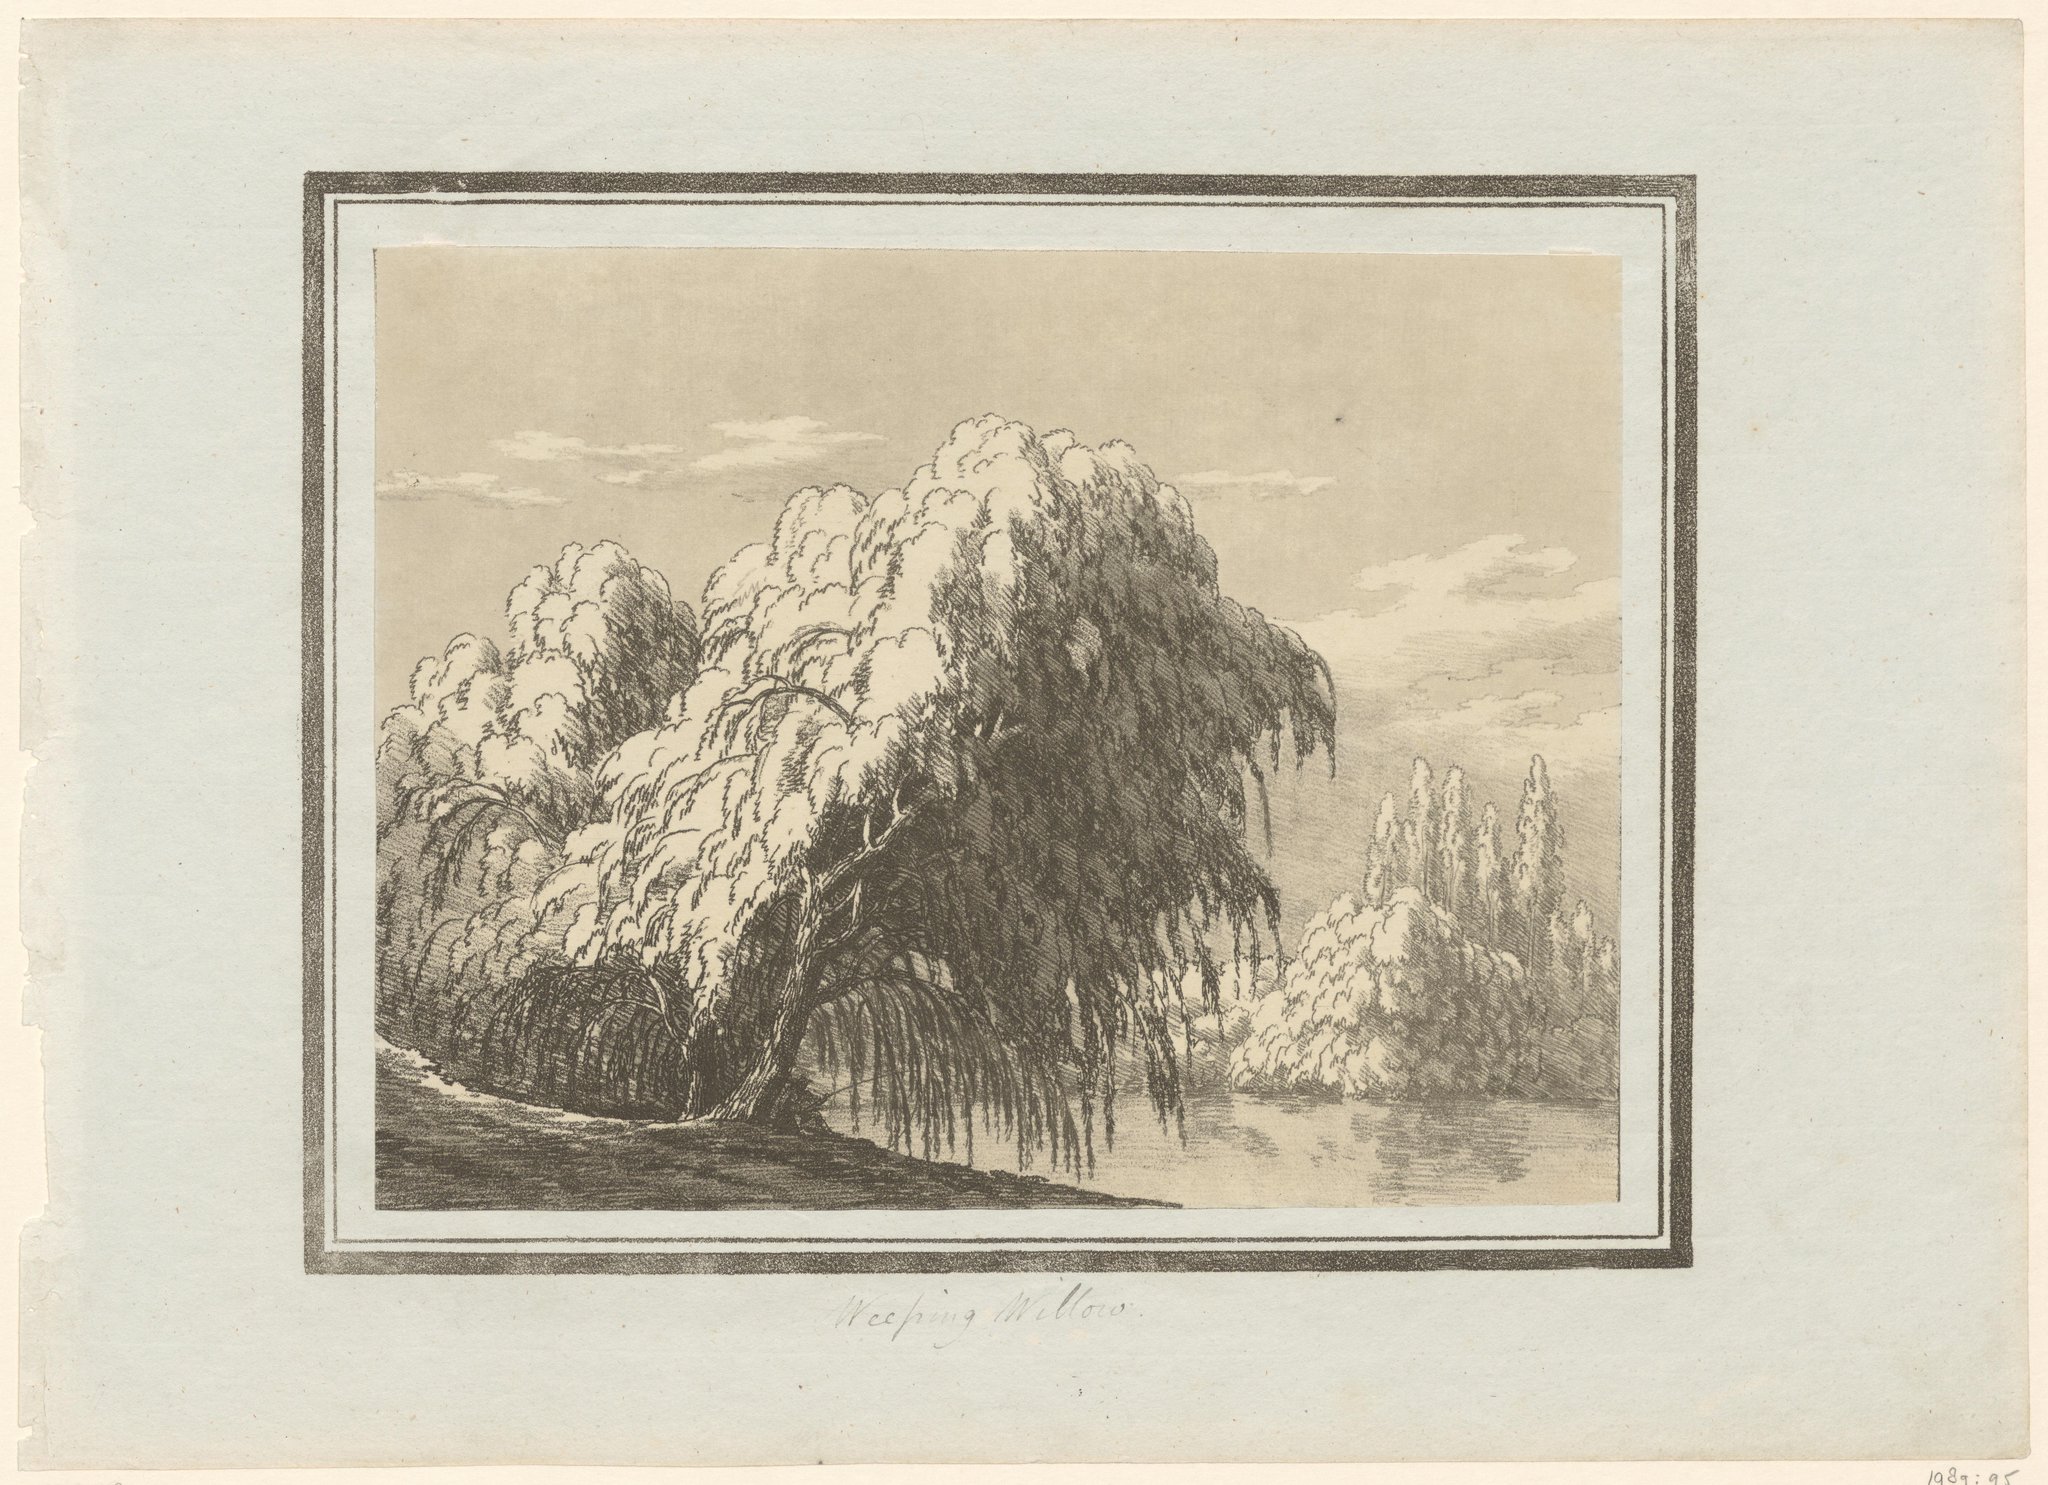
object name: print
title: Treurwilg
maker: john robert cozens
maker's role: draughtsman, print maker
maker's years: 1752-1797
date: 1789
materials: paper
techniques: aquatint, soft ground etching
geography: london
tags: trees: weeping willow, brook, angling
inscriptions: collector's mark: Lugt 2760, title: ‘Weeping Willow.’, collector's mark: Lugt 2228